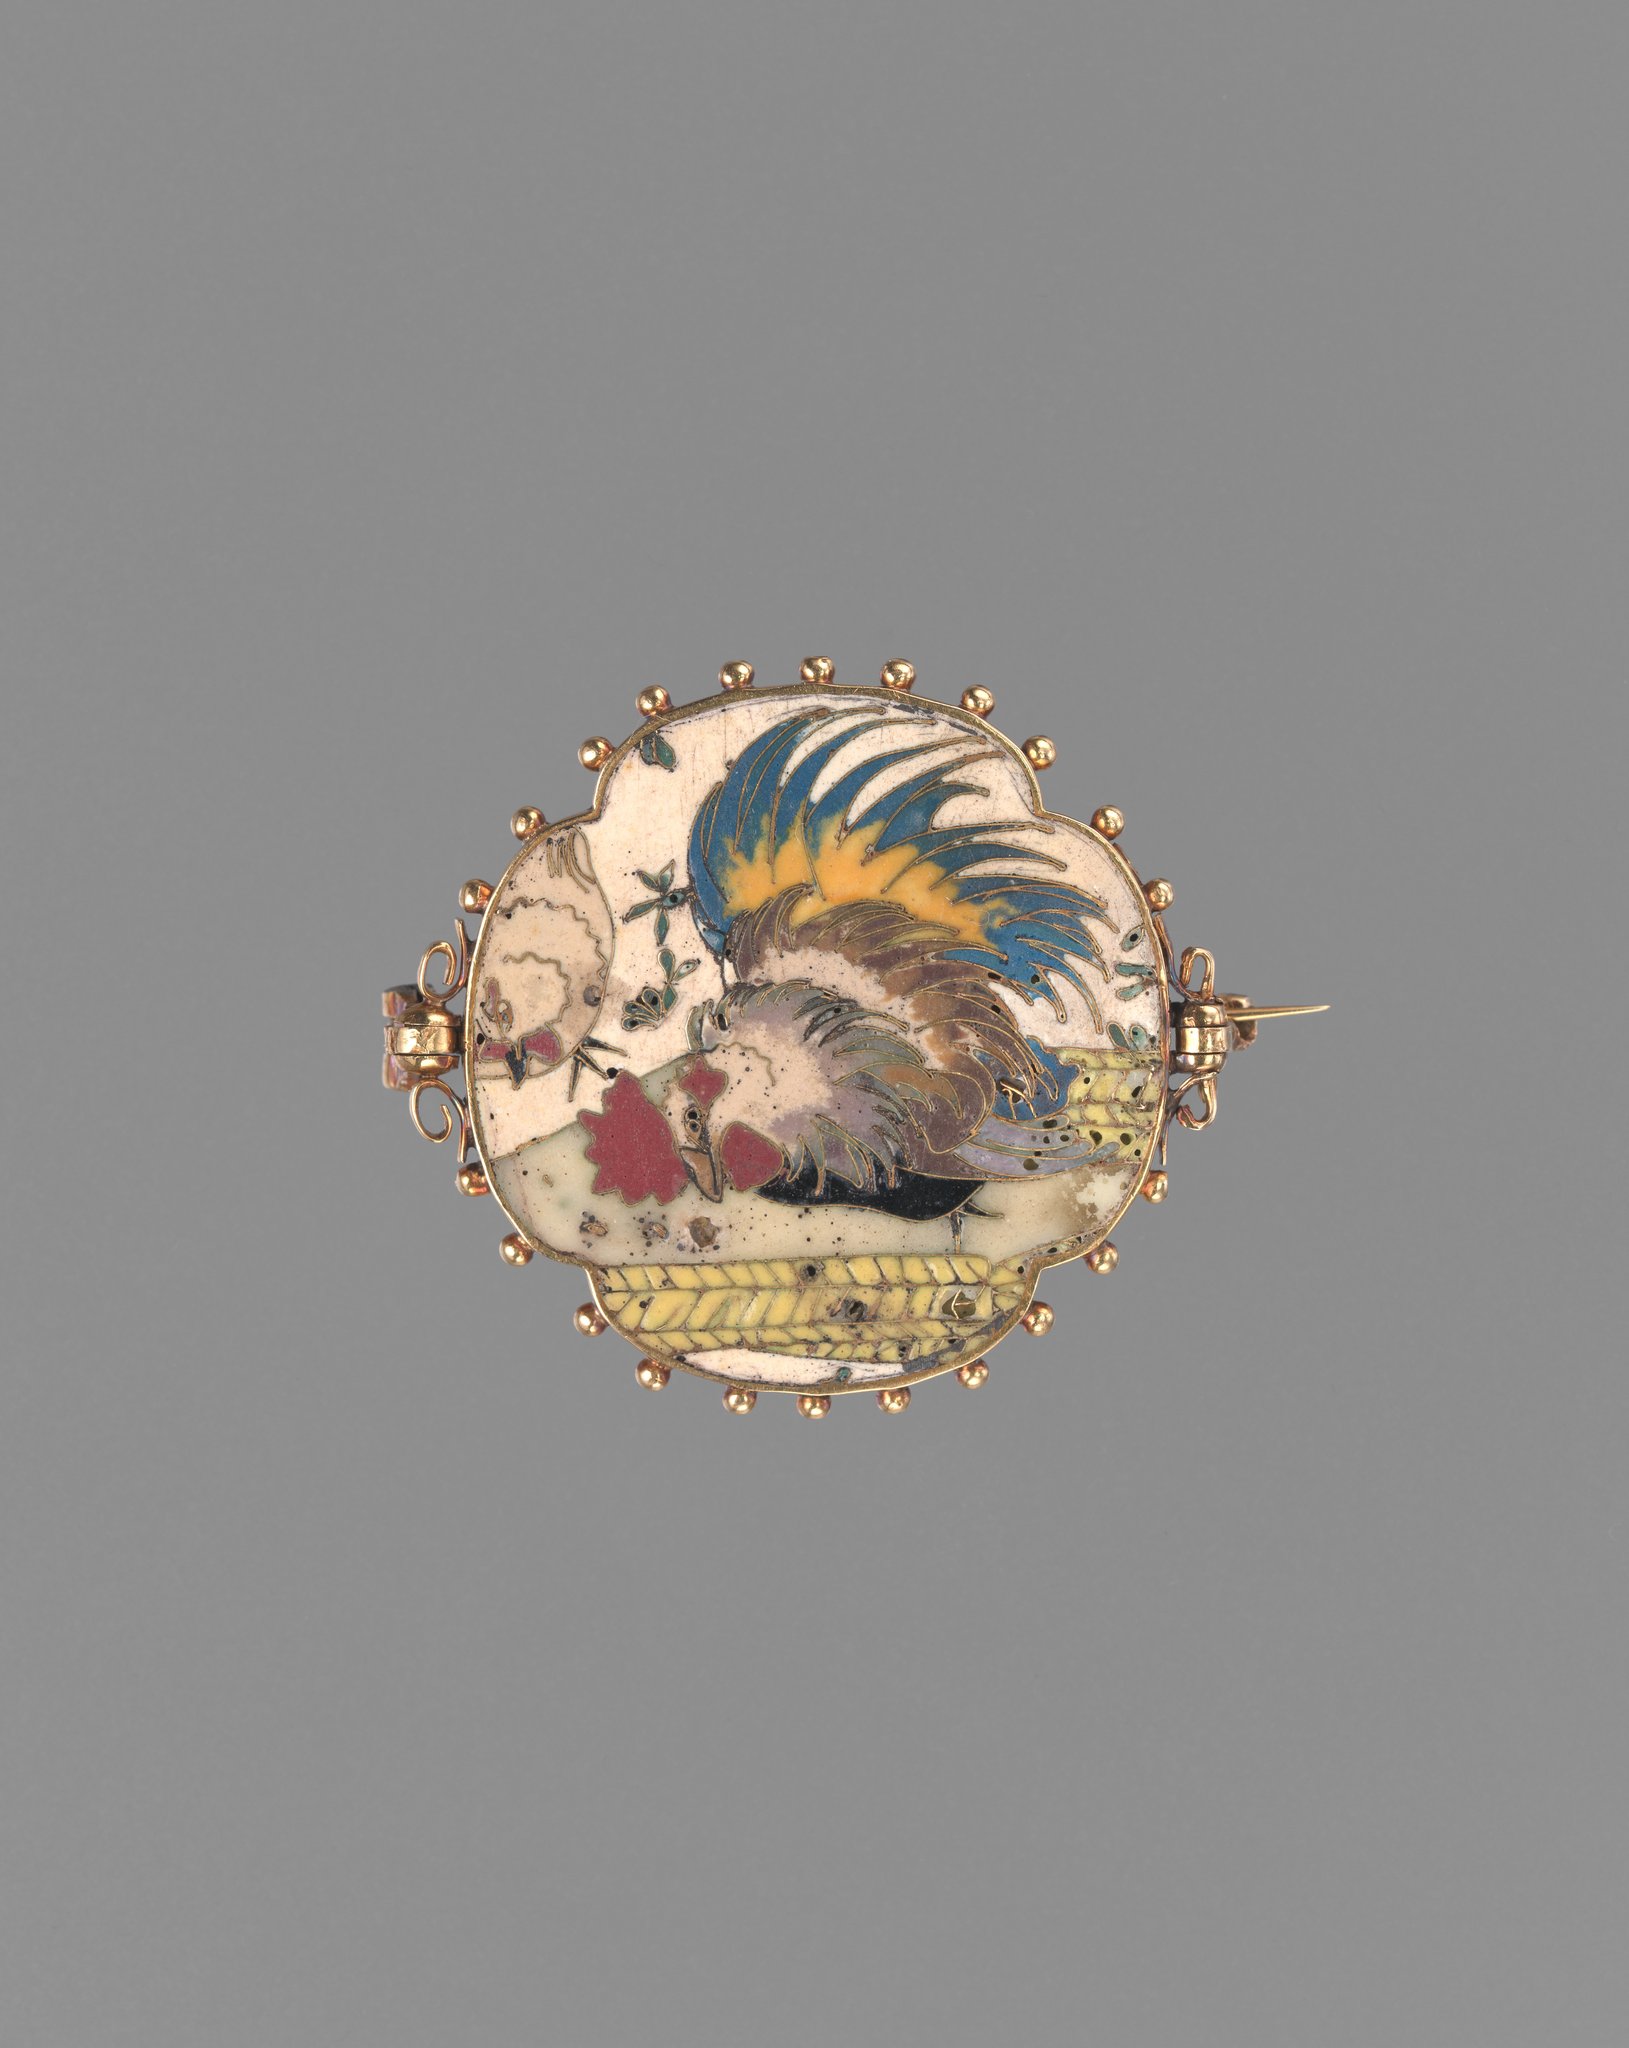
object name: brooch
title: Reversible brooch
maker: alexis falize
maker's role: maker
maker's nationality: french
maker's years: 1811-1898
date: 1869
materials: enamel, gold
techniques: enamel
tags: roosters